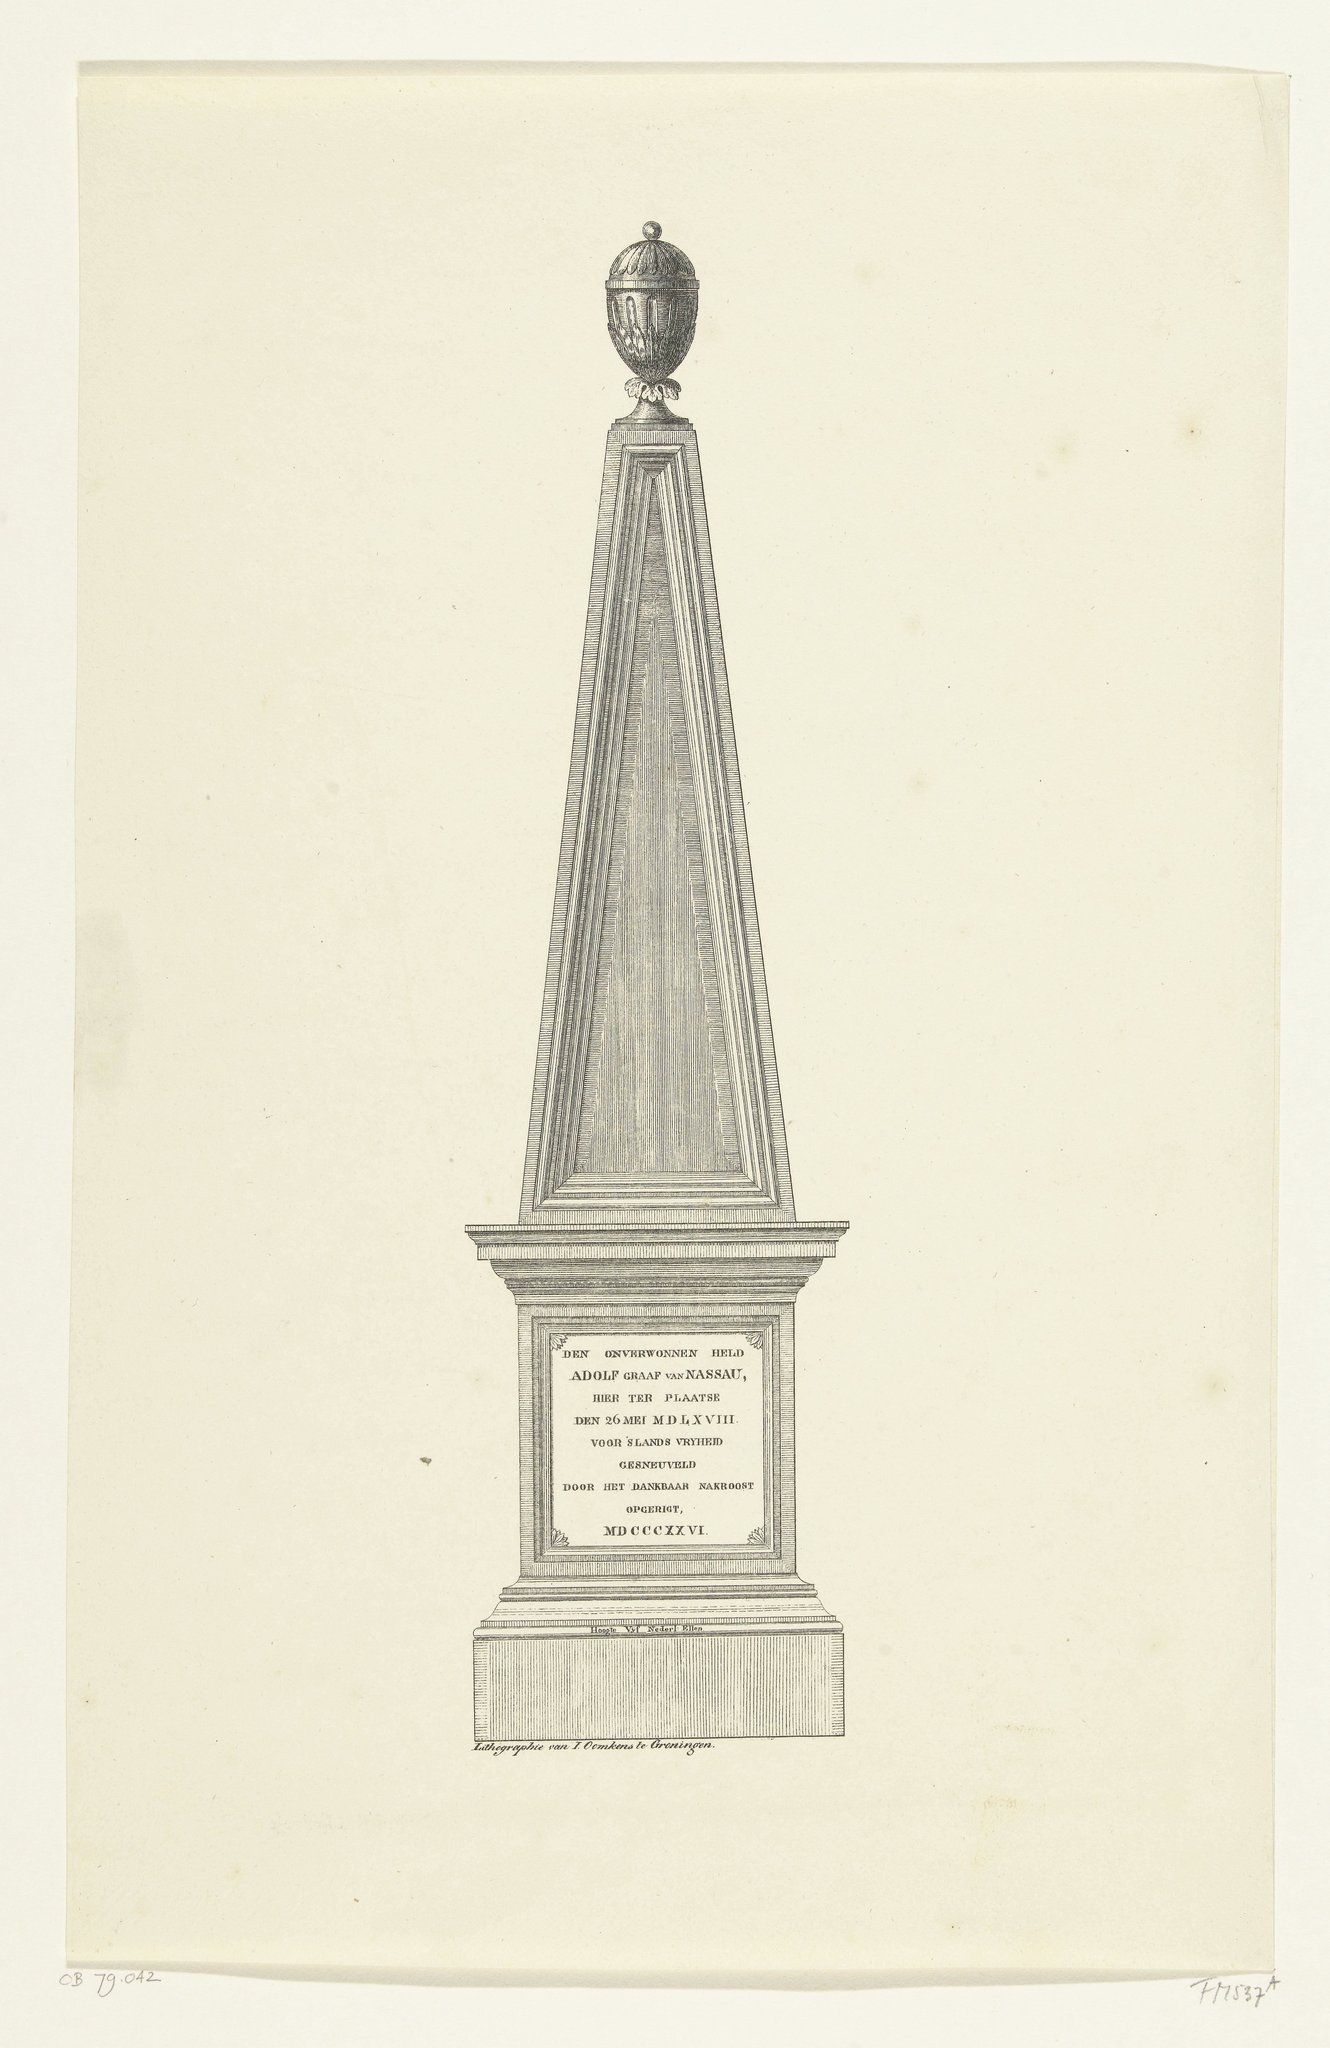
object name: historical object representation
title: Het monument voor Adolf graaf van Nassau, gesneuveld tijdens de slag bij Heiligerlee, opgericht in 1826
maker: jan oomkens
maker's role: bookseller, printer, publisher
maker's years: 1779-1844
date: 1826-1829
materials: paper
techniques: lithograph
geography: groningen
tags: monument, statue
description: Het monument voor Adolf graaf van Nassau, gesneuveld tijdens de slag bij Heiligerlee (23 mei 1568), opgericht in 1826. Op het basement van de naald staat een tekst ter ere van graaf Adolf.